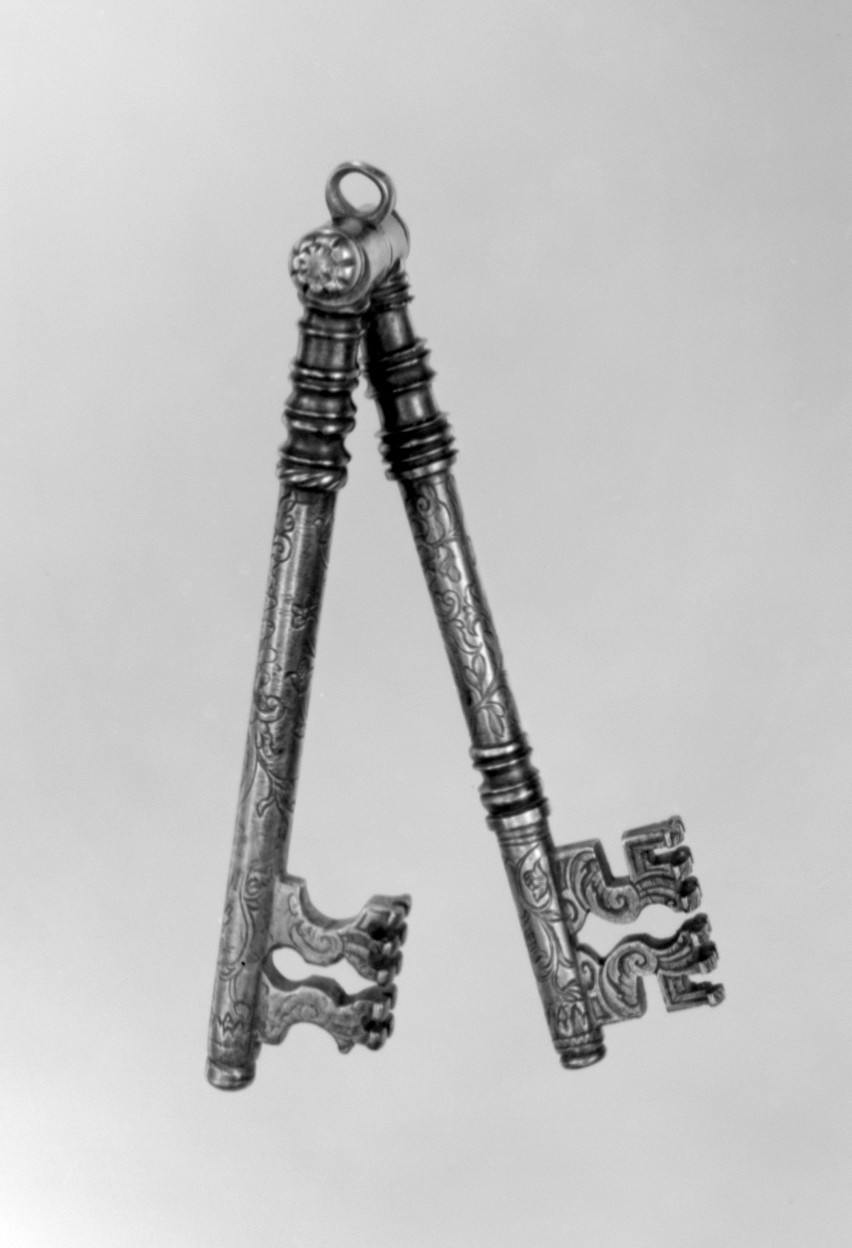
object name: double key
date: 1701-1800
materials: iron